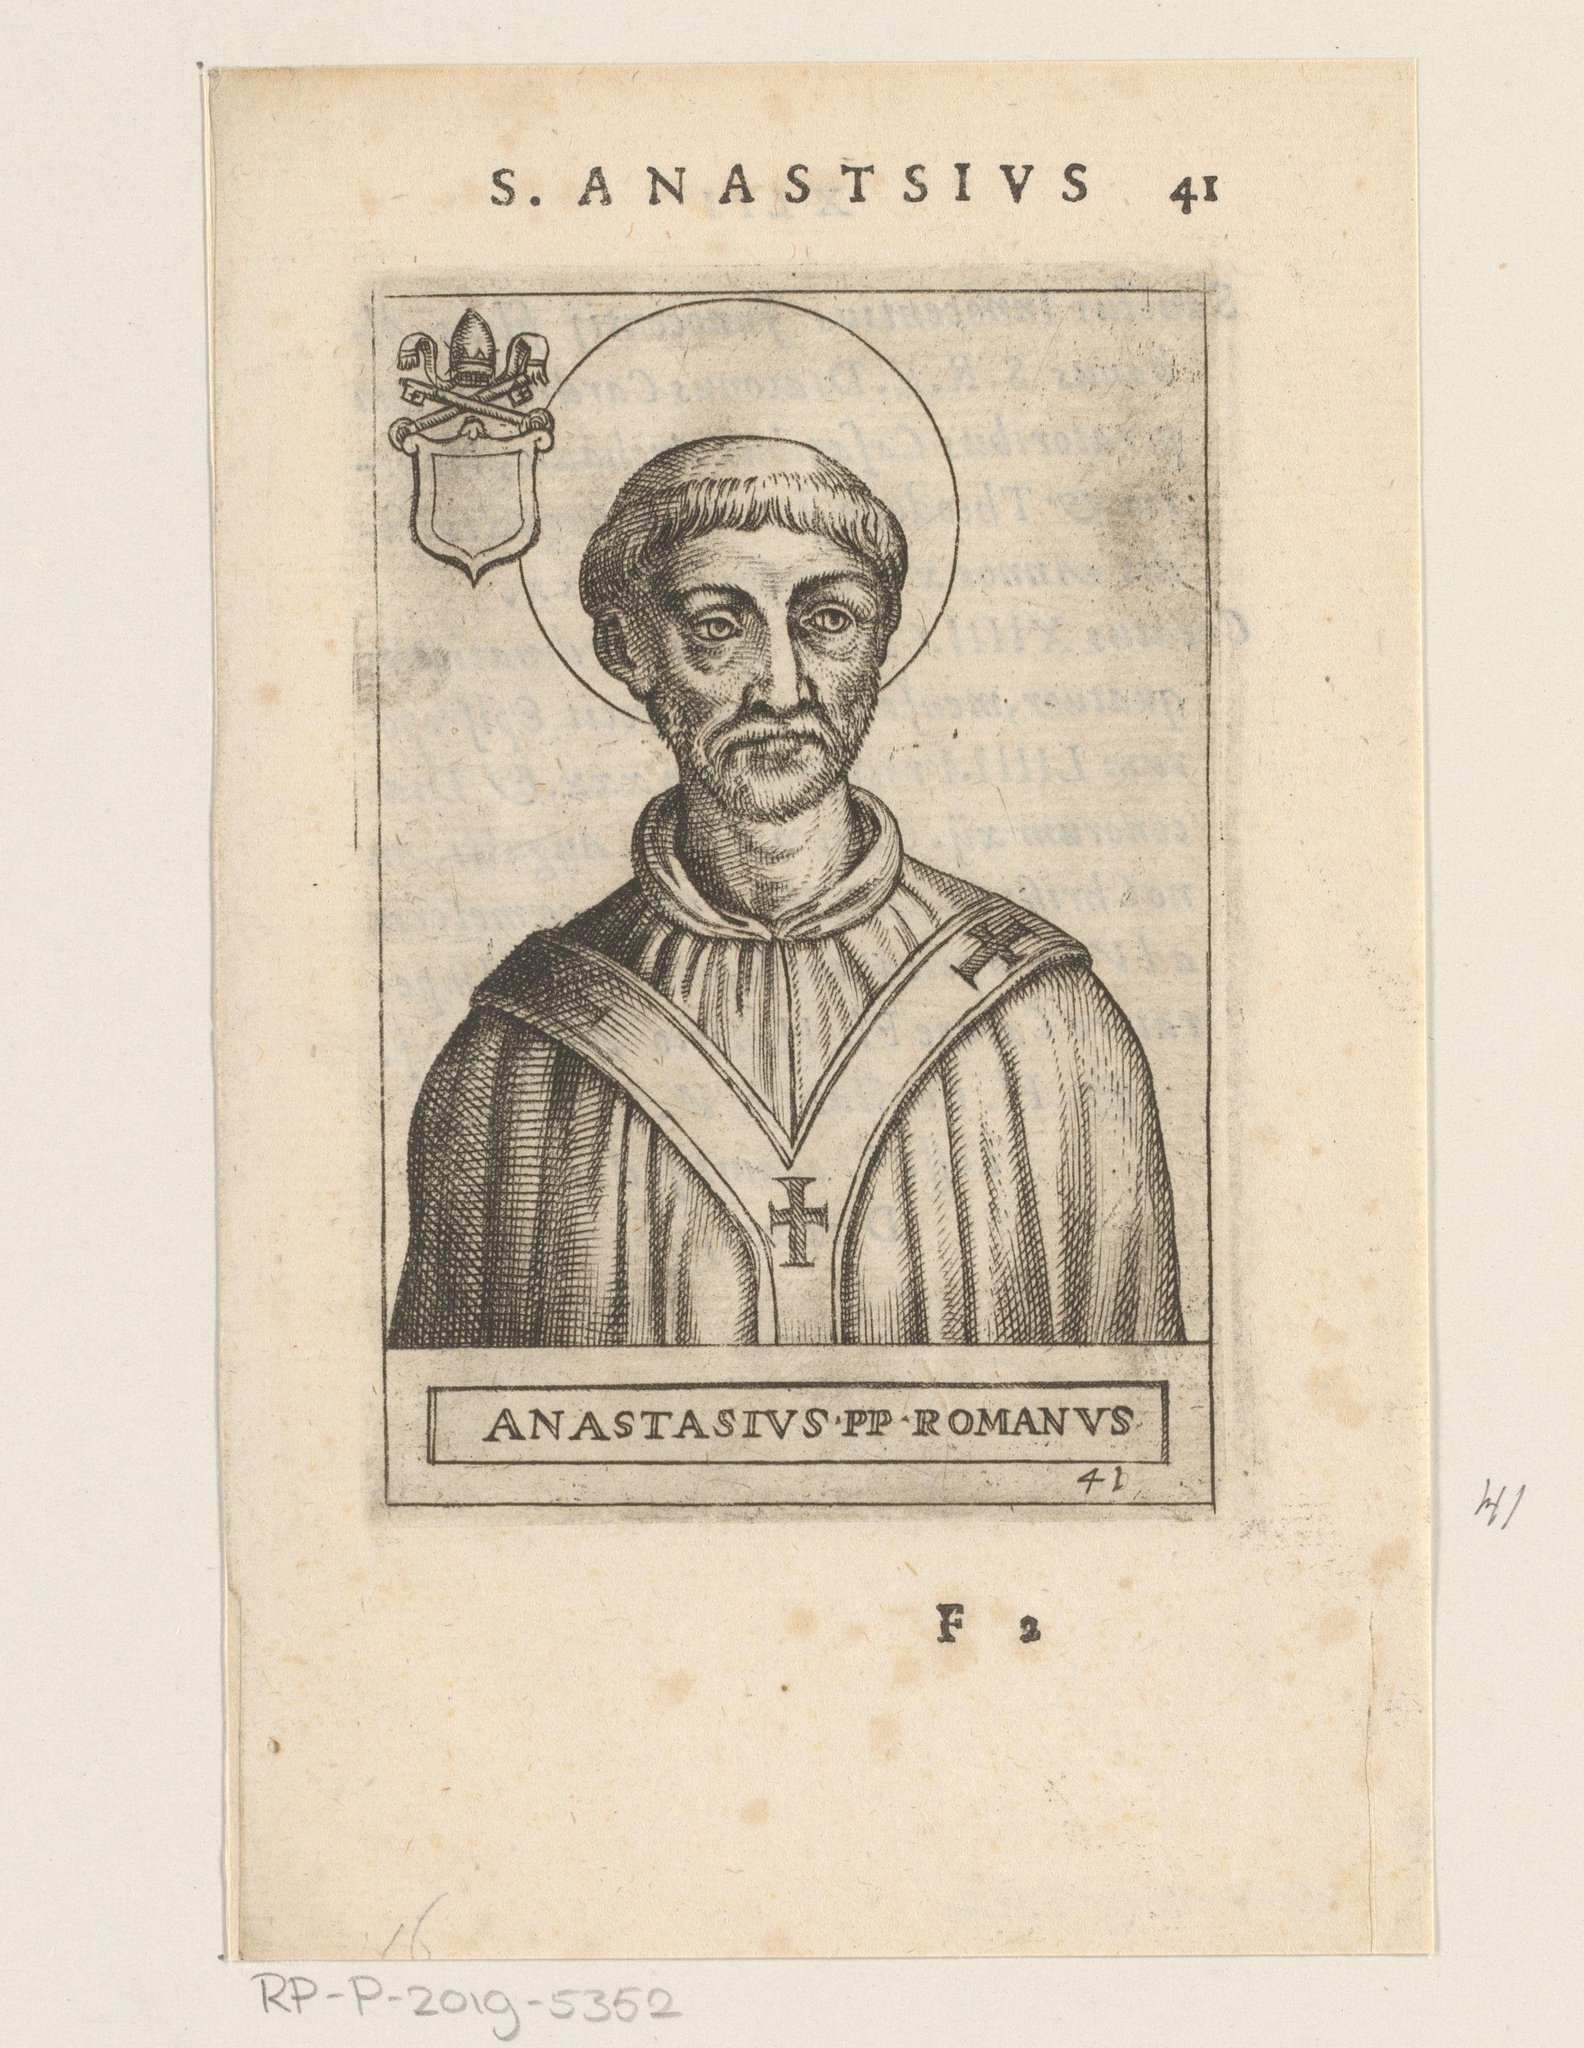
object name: print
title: Portret van paus Anastasius I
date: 1595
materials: paper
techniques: engraving, letterpress printing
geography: rome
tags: historical persons, pope, armorial bearing, heraldry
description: Prent uit: Cavalieri, Giovanni Battista de'. Effigies pontificum romanorum cum eorum vitis (...). Rome: Bartolomeo Bonfadino, 1595. Prent voor het eerst verschenen in: Cavalieri, Giovanni Battista de'. Pontificum romanorum effigies (...). Rome: Domenico Basa en Francesco Zanetti, 1580. Prent ook gebruikt in latere publicaties.